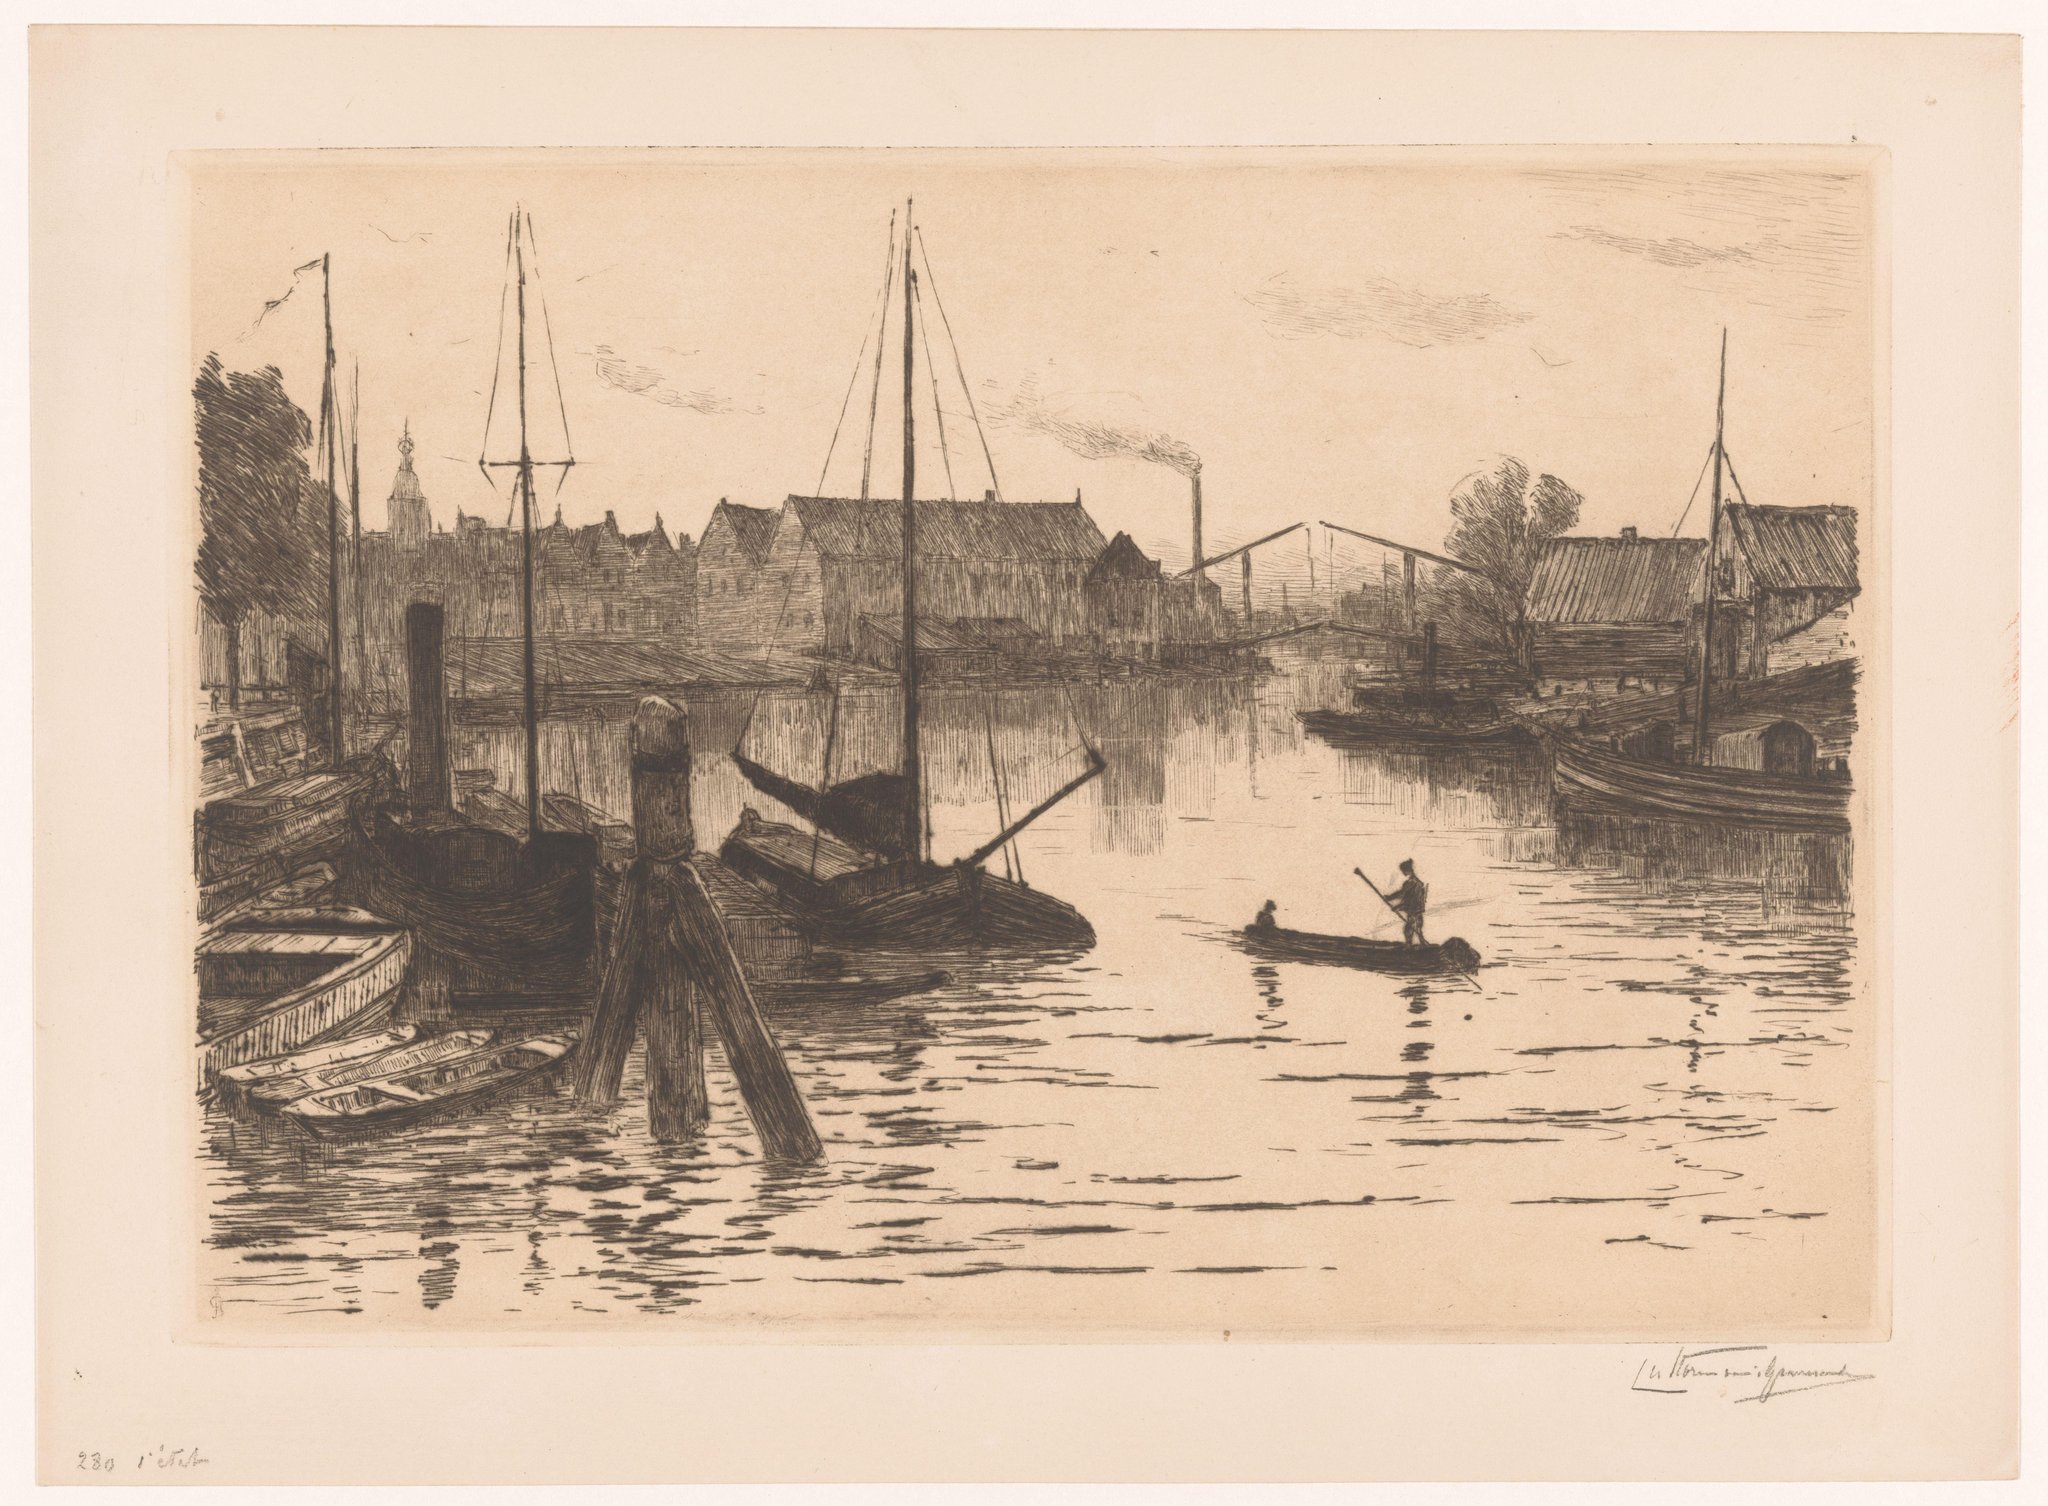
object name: print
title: Dordrecht, Rietdykshaven, le soir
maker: carel nicolaas storm van s-gravesande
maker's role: draughtsman, print maker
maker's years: 1841-1924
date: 1887-1889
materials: paper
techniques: drypoint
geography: netherlands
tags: harbour, evening, dordrecht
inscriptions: collector's mark: Lugt 2228, number: ‘280’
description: Mogelijk ook vermeld in: Storm van 's-Gravesande, Charles. Catalogue des eaux-fortes et lithographies. New York: s.n., 1903, of in een onbekende latere uitgave van het manuscript. Vermoedelijk vermeld als catalogusnummer 280.